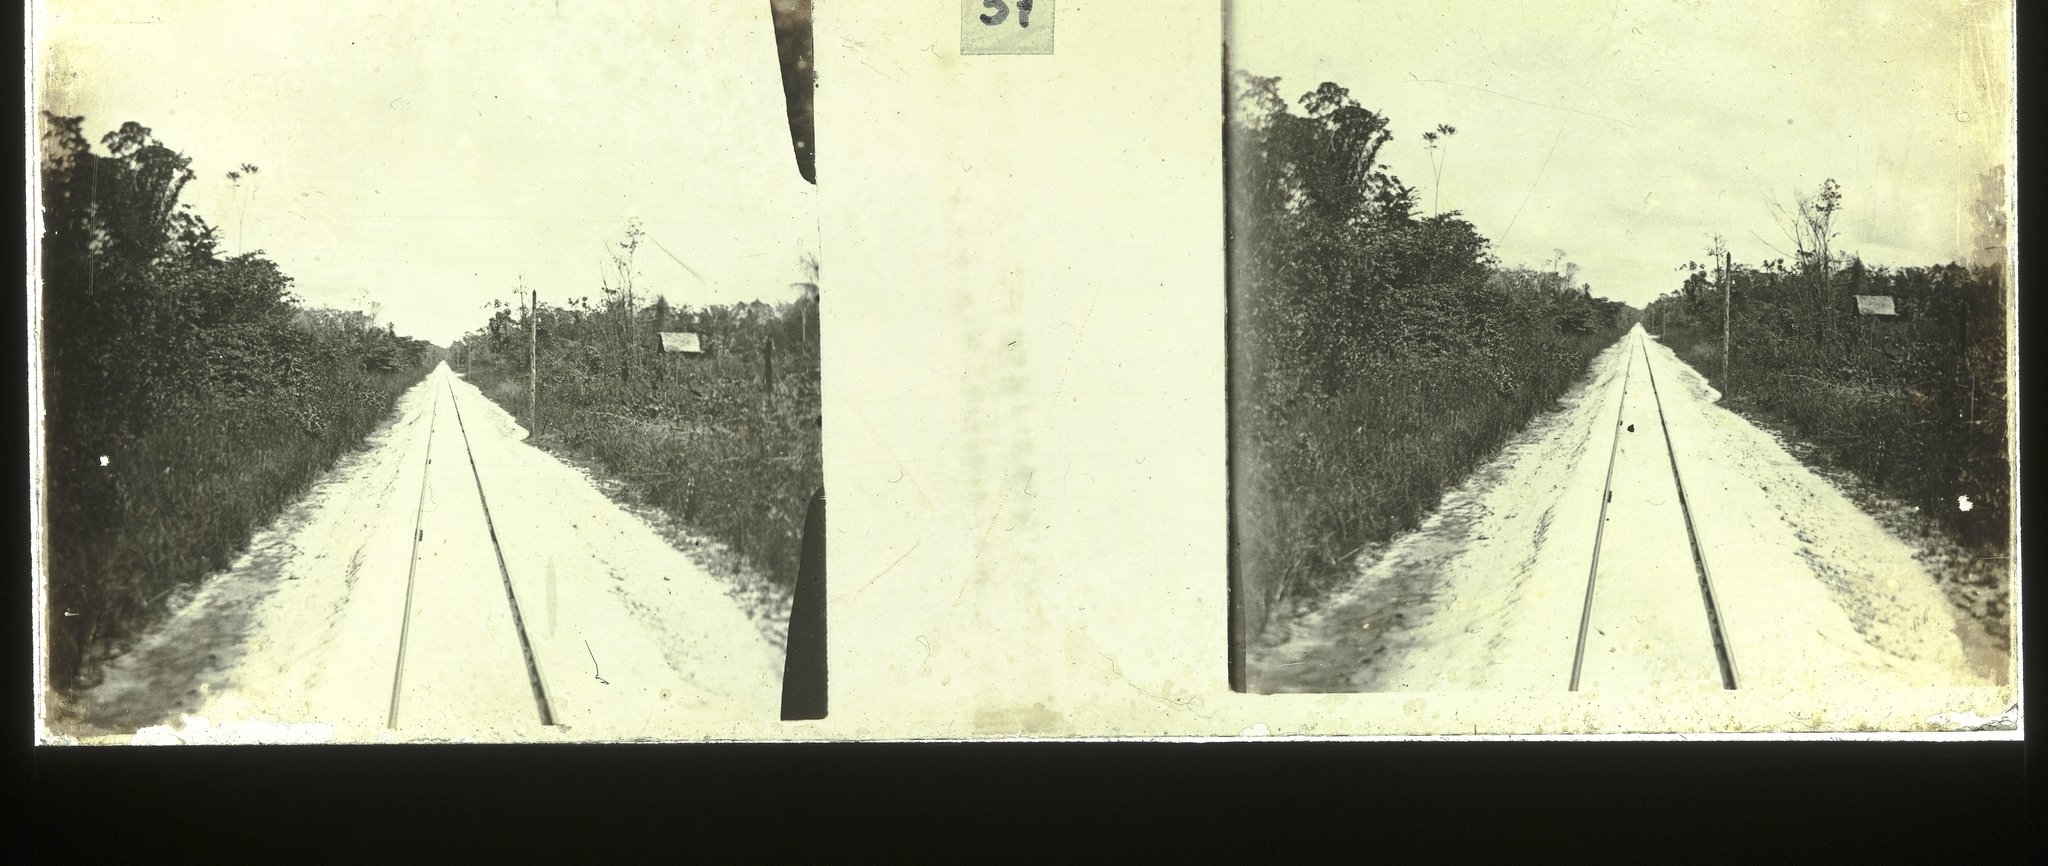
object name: stereograph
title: Spoorlijn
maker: theodoor brouwers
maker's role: amateurfotograaf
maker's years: 1874-1932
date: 1913-1930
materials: glass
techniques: photography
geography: suriname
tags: amsterdam, theodoor brouwers, railway, train, suriname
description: In de periode 1911-1932 woonde op plantage Accaribo in Suriname de familie Brouwers van wie de foto's afkomstig zijn. Rond 1910 vond Theodoor Brouwers werk op plantage Accaribo. In 1929 werd hij eigenaar van de plantage. Op Accaribo werden in zijn tijd bananen geproduceerd en wat koffie.